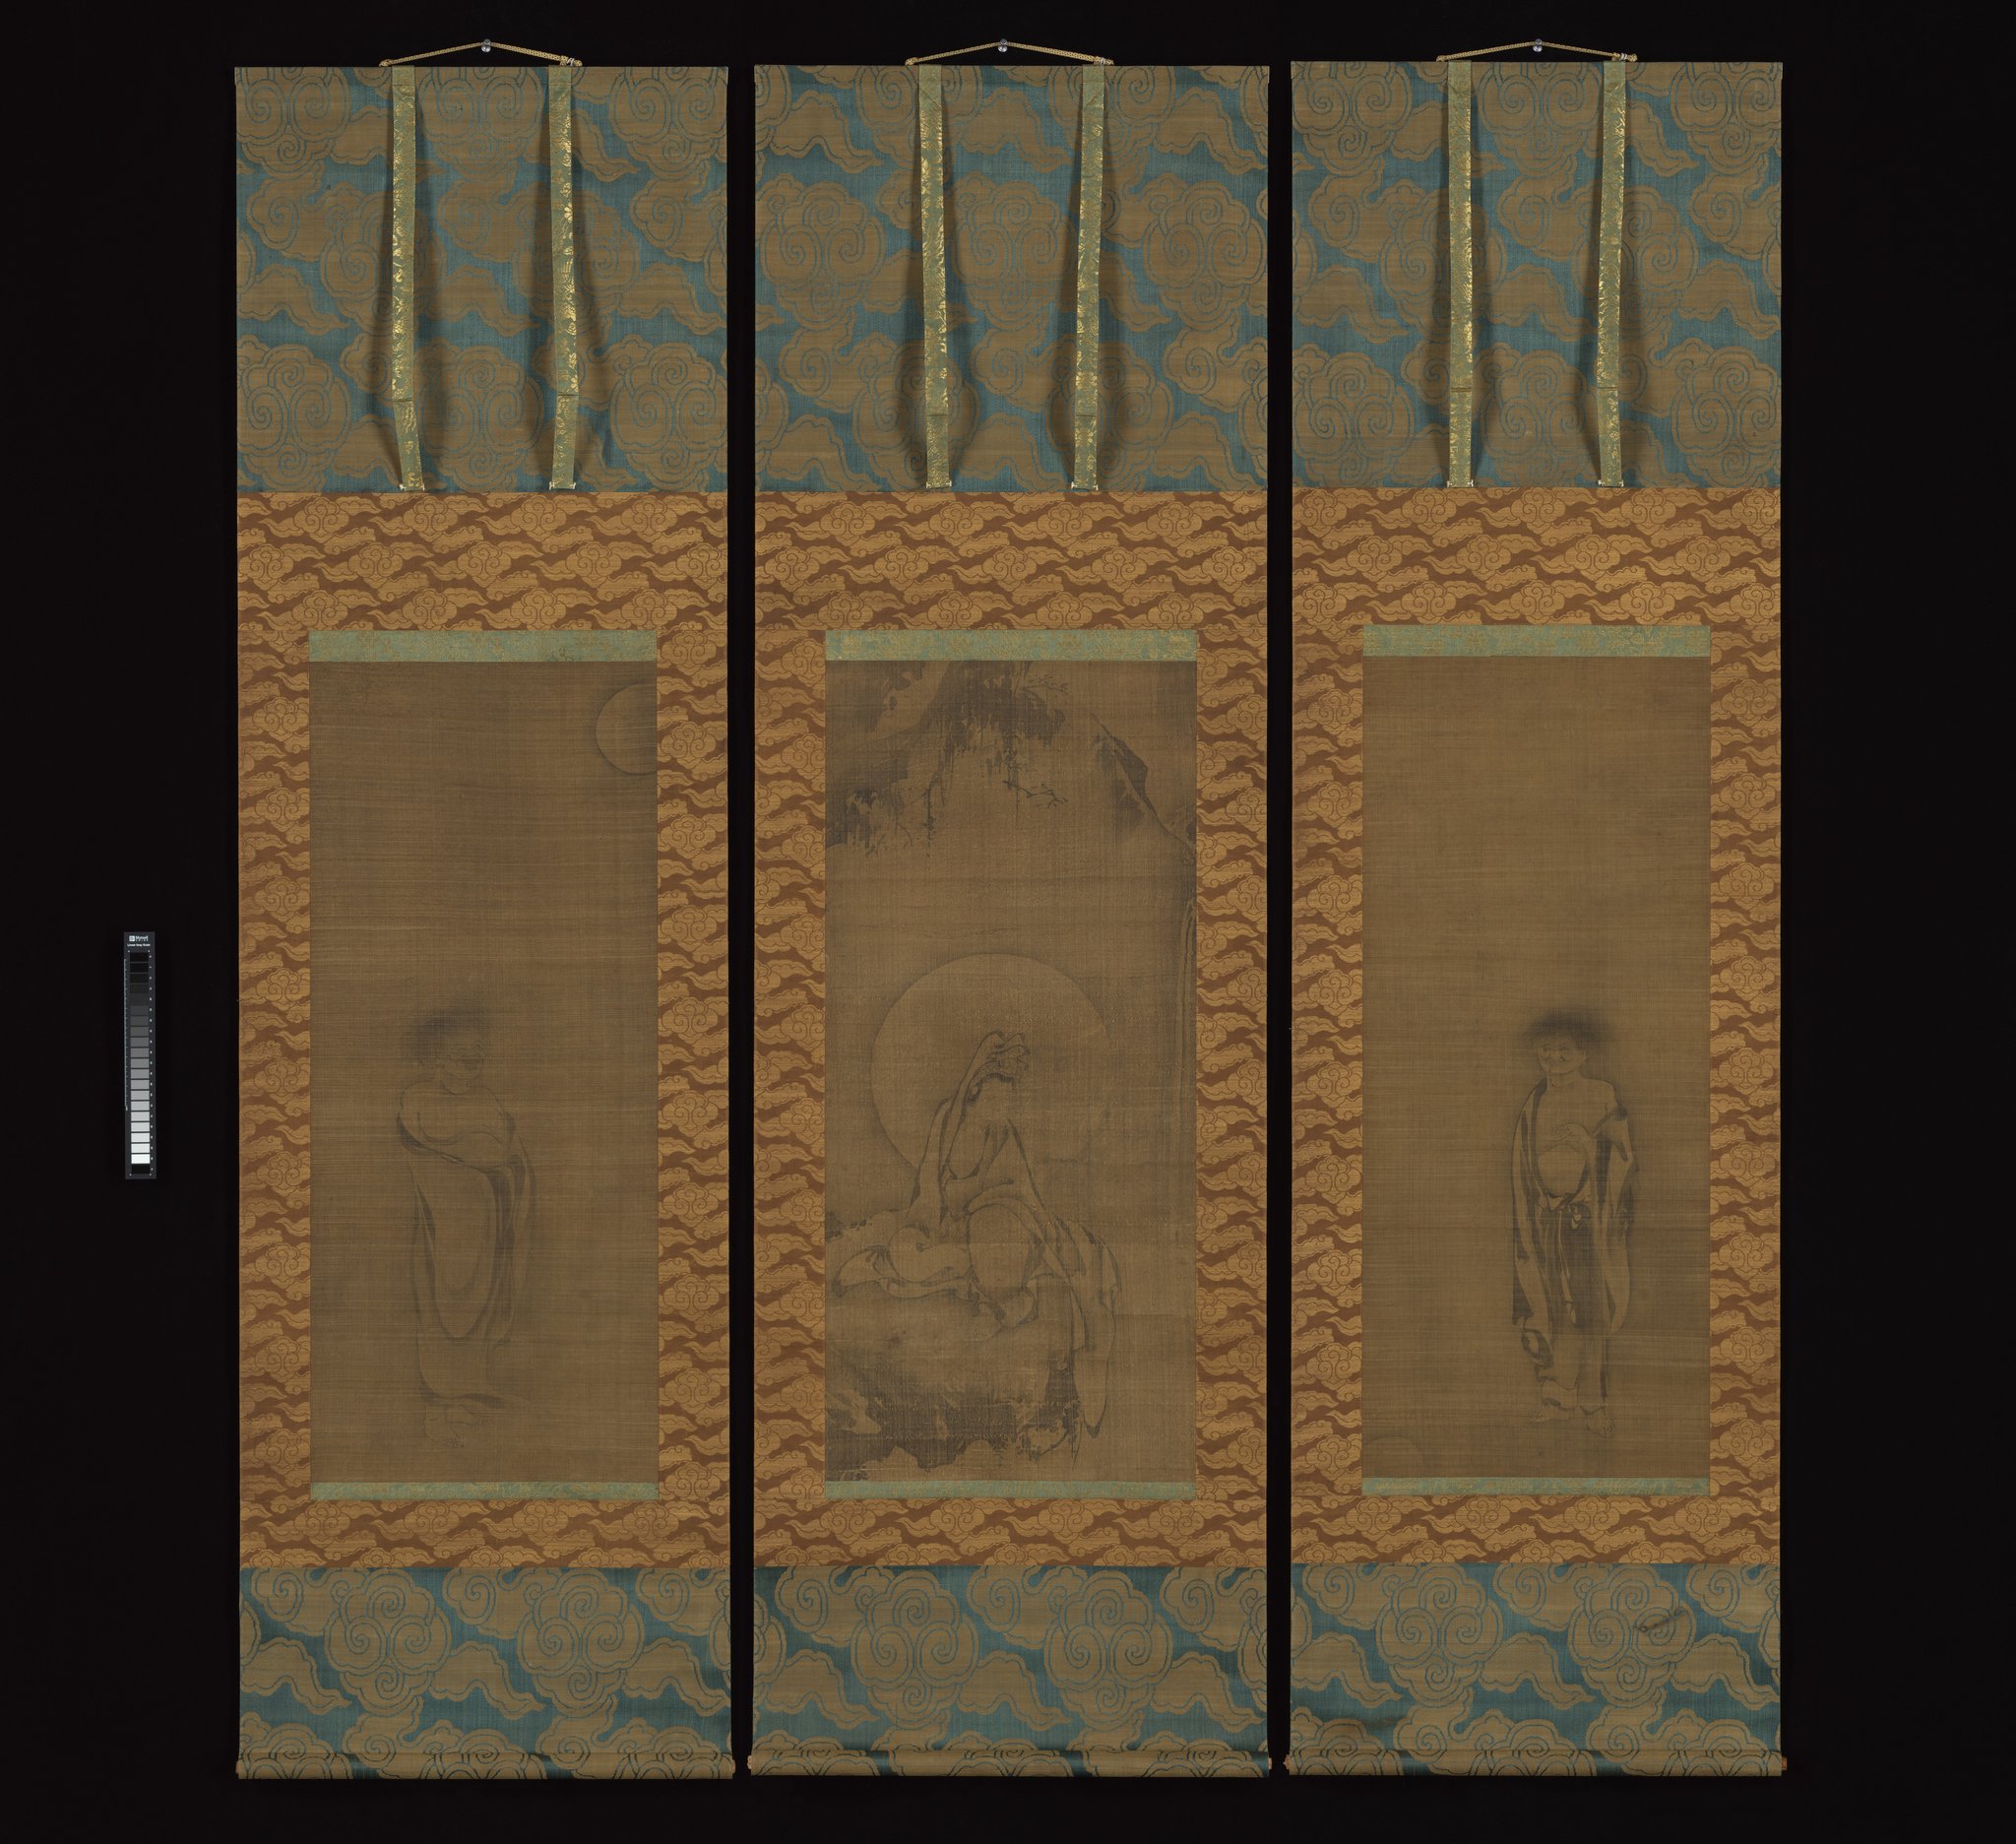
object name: hanging scroll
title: White-Robed Kannon, Kanzan, and Jittoku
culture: japanese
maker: unidentified artist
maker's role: artist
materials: ink, silk